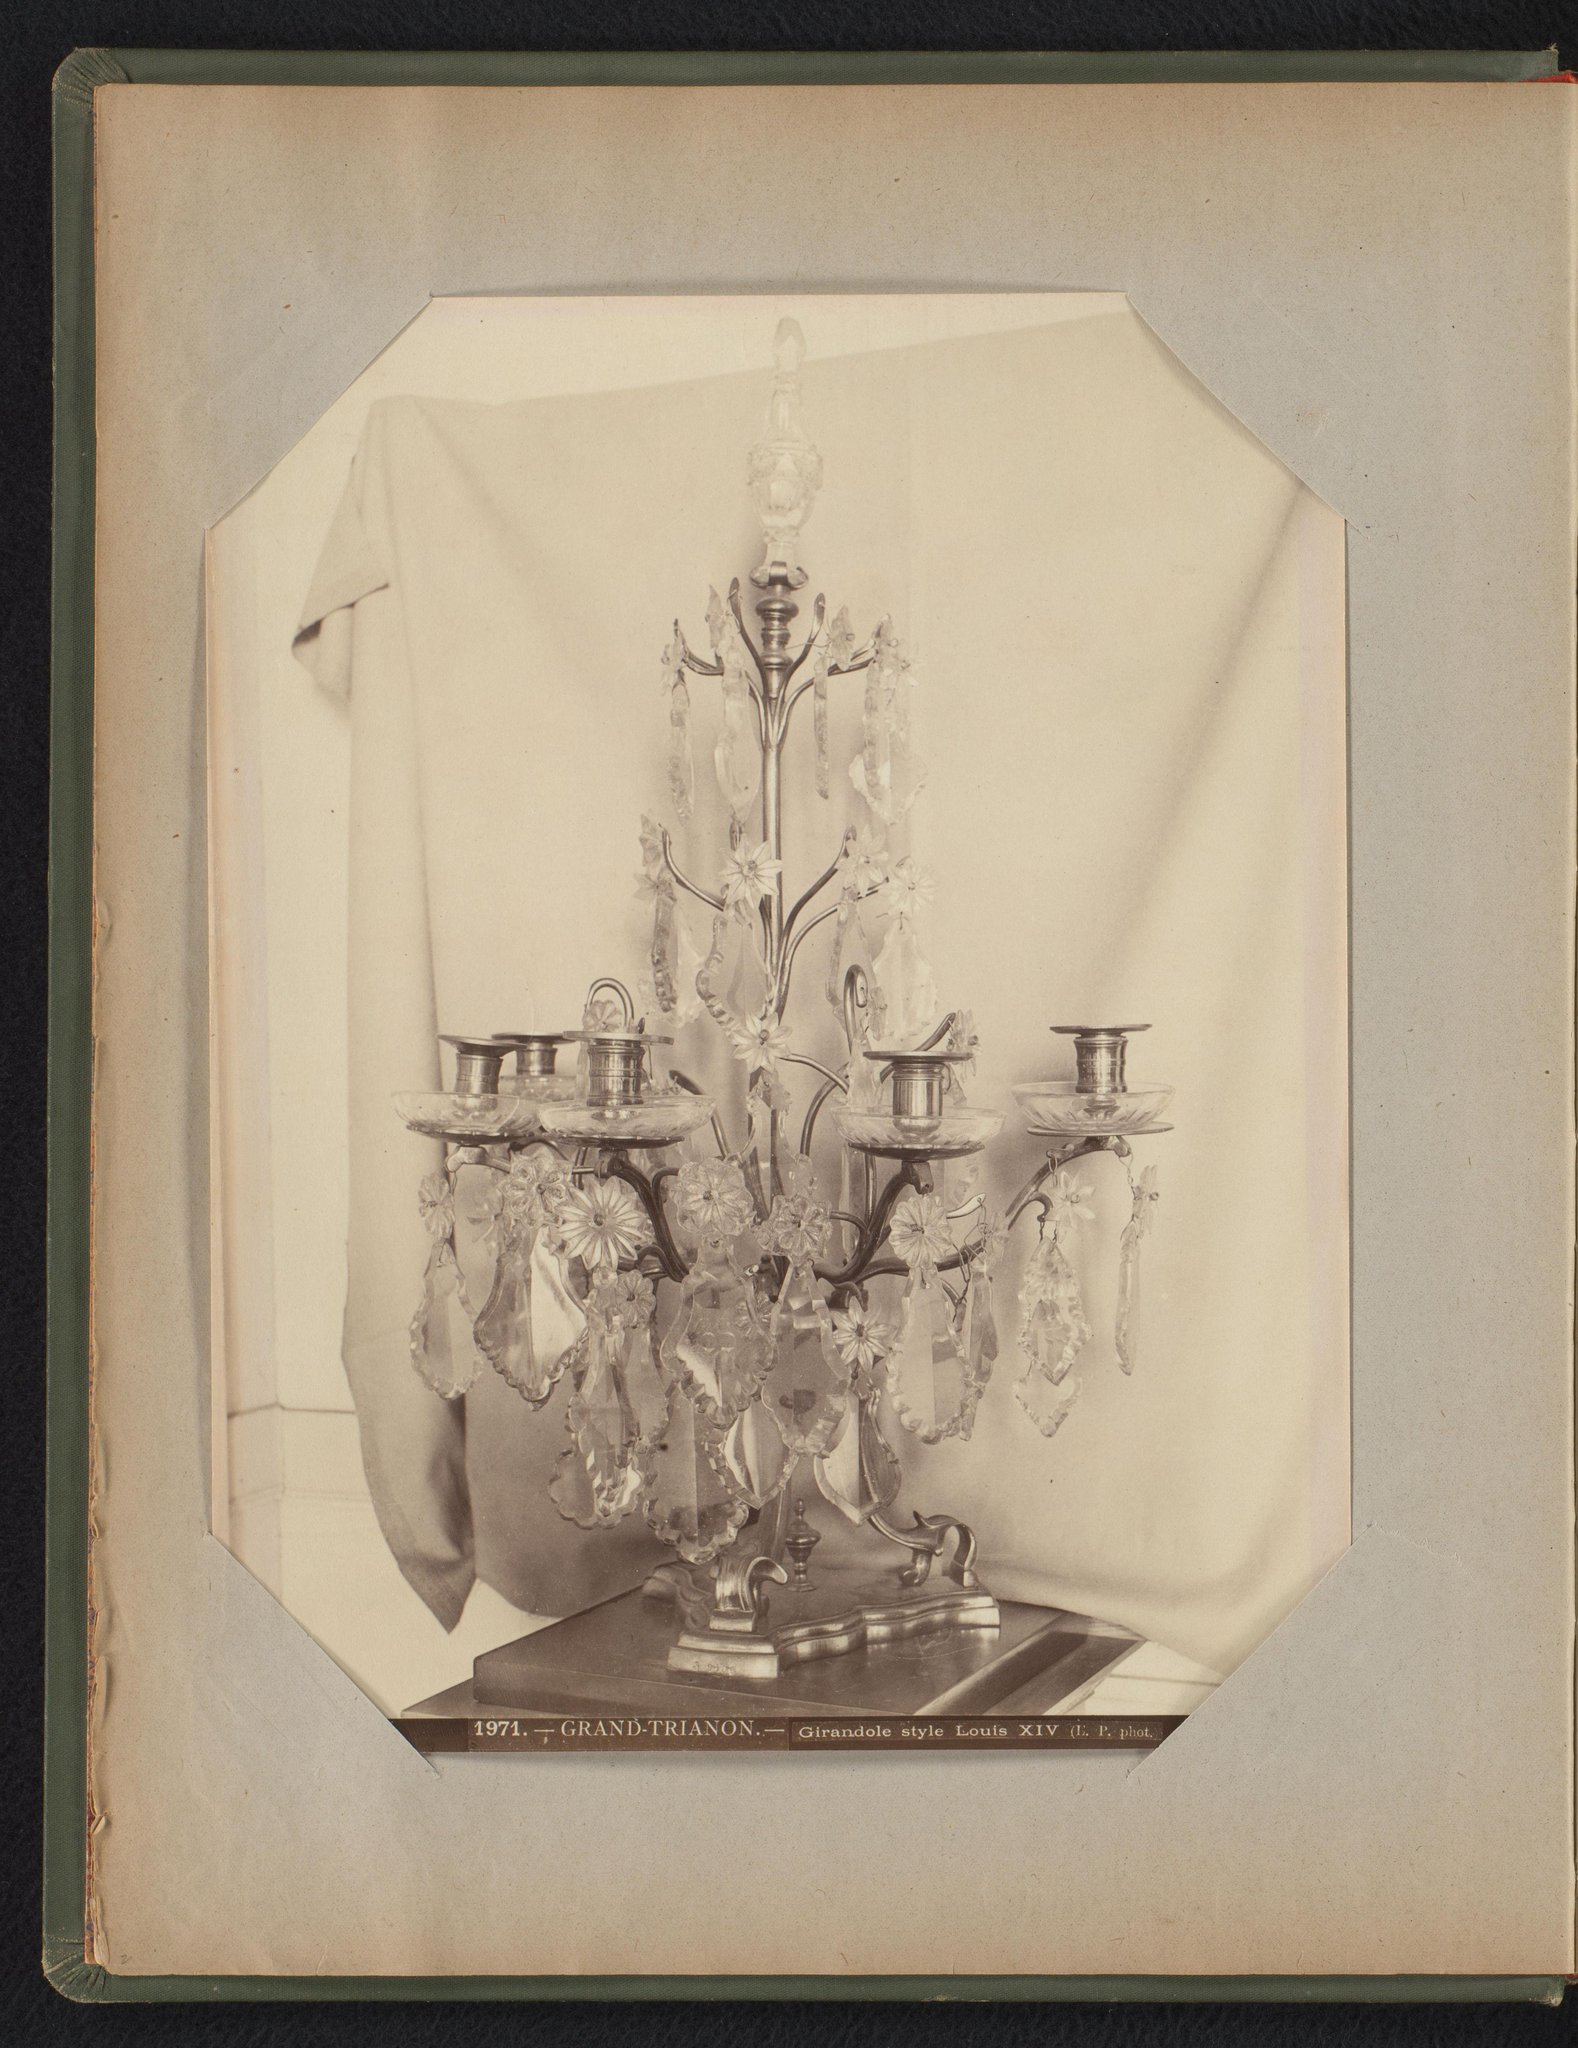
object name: photograph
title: Zes armige kandelaar met hangende kristallen afkomstig uit het Grand Trianon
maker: Anonymous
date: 1860-1900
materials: canvas, cardboard, paper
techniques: matte daylight collodion silver print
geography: netherlands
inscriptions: annotation: ‘1971. - Grand Trianon.- Girandole style Louis XIV (E.P. phot)’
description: Onderdeel van een serie met betrekking tot het interieur van het paleis van Versailles met kroonluchters, deuren, portalen en meubelstukken.